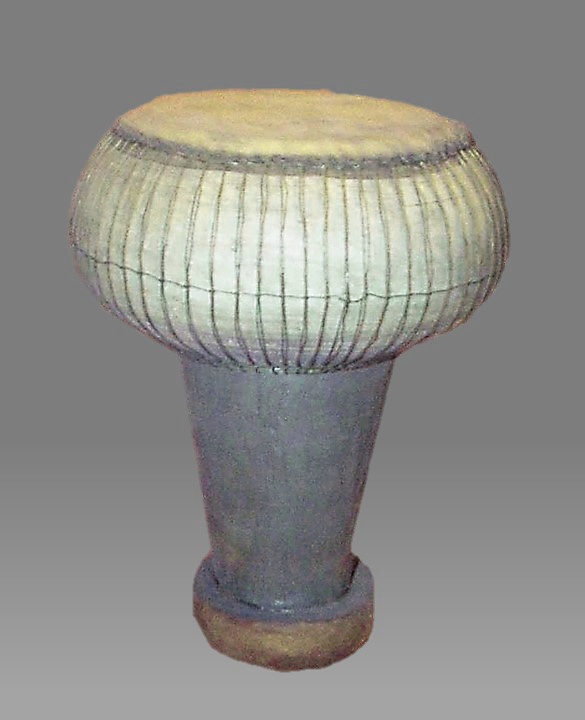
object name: thon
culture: thai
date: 1867-1900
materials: skin, tin, wood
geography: thailand